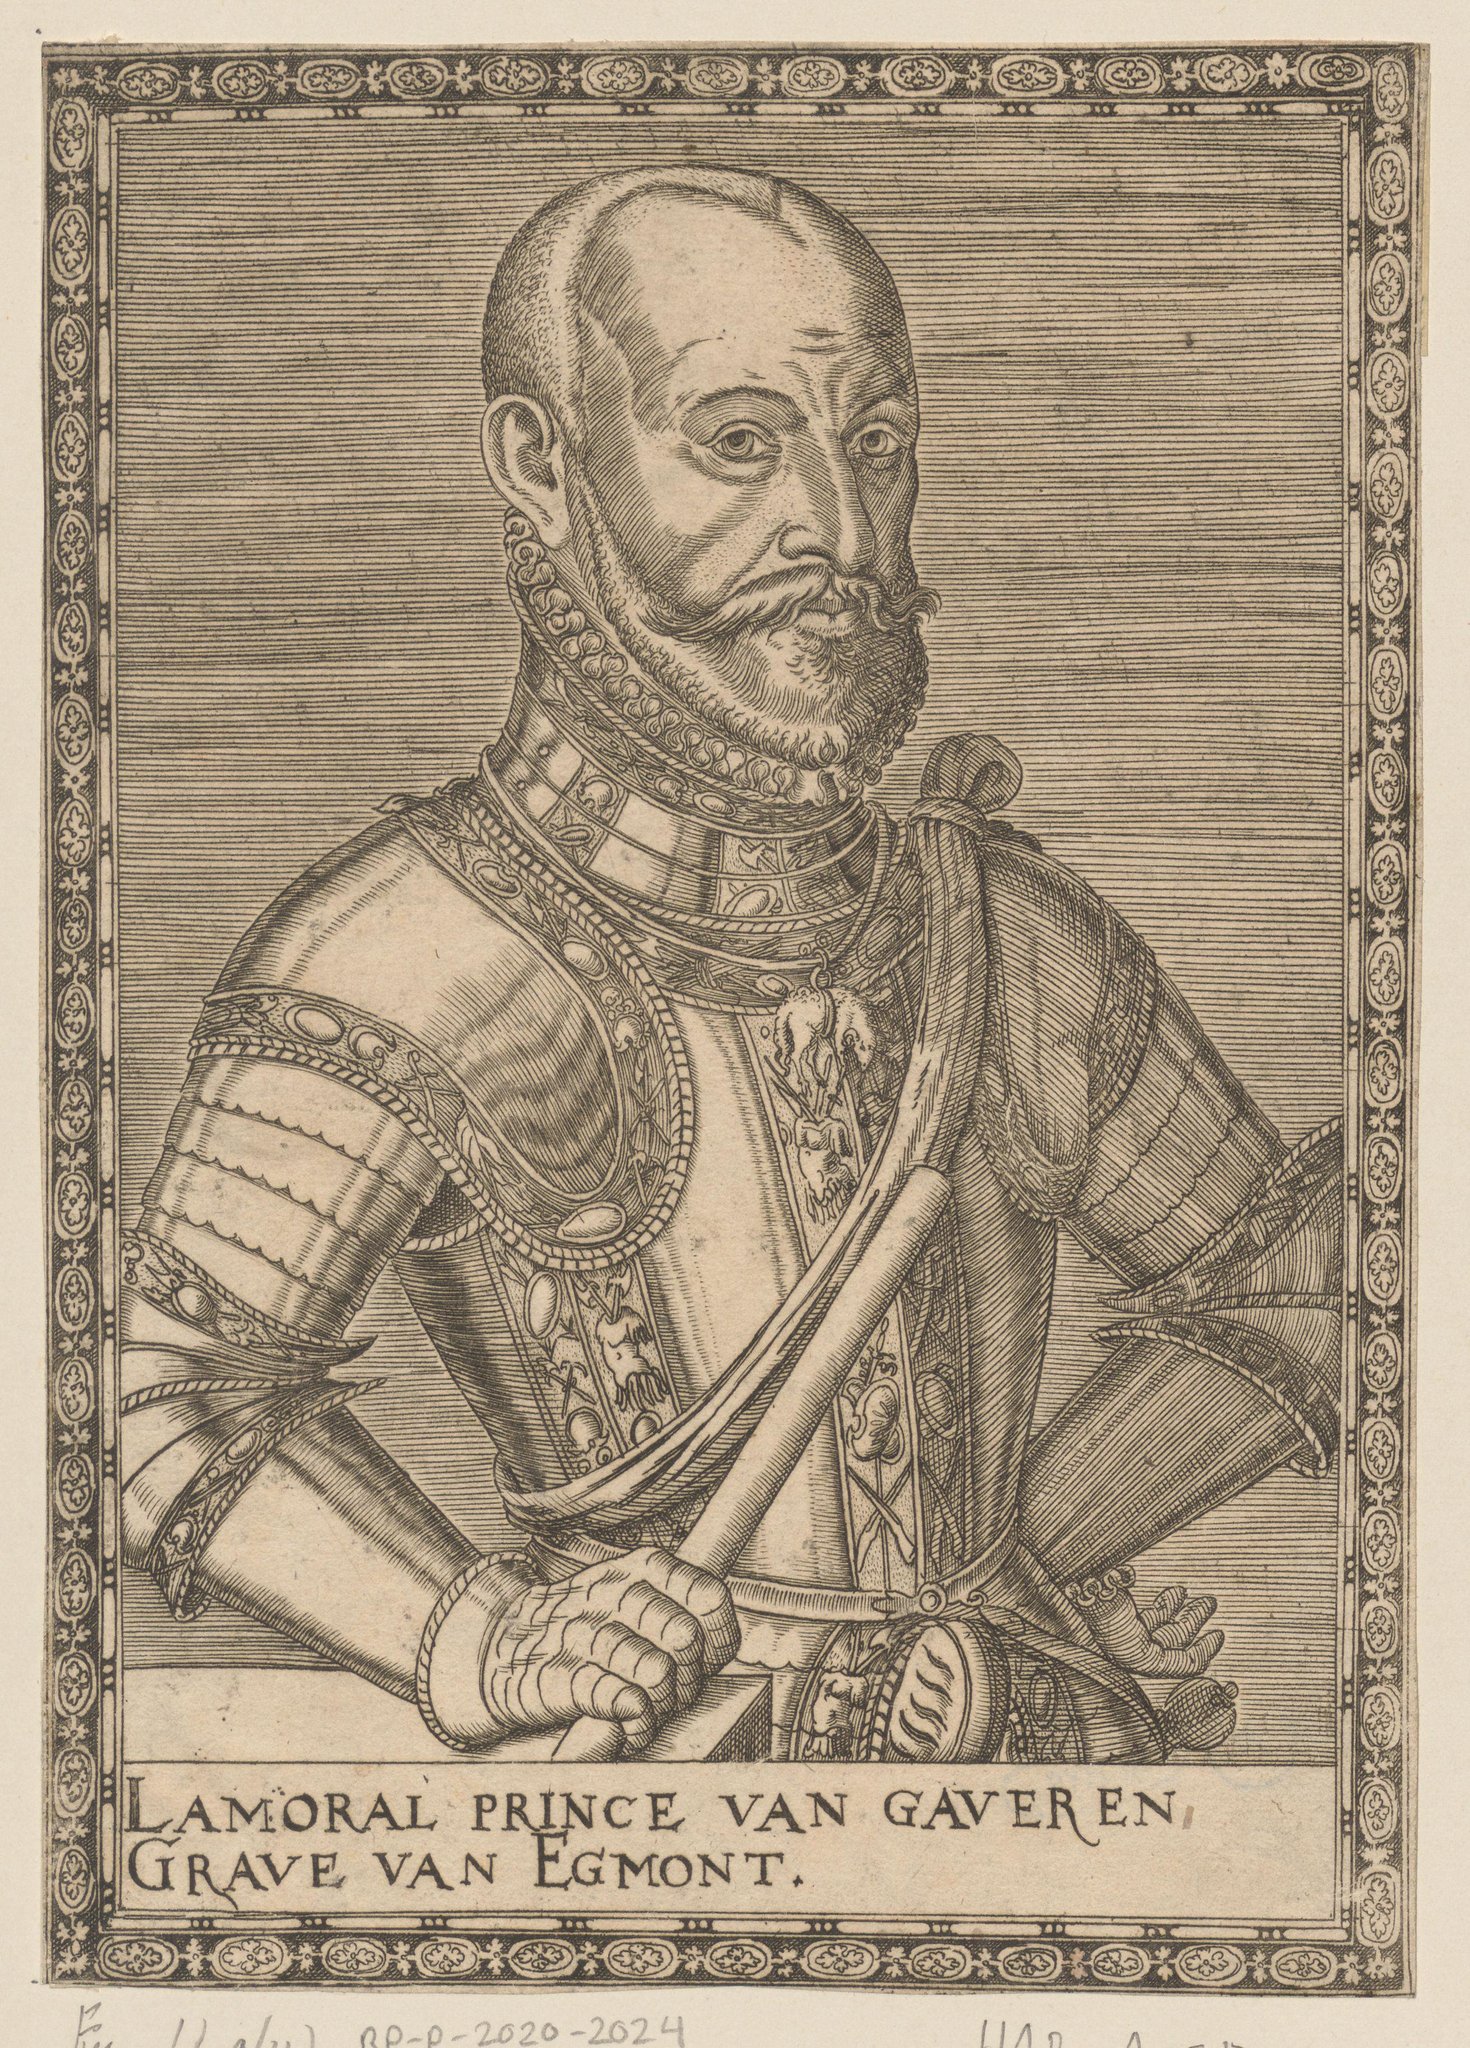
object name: print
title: Portret van Lamoraal van Egmond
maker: Anonymous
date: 1568-1620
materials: paper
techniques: engraving, etching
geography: northern netherlands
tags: brussels, earl, armour, historical persons, knighthood order of the golden fleece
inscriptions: collector's mark: Lugt 964